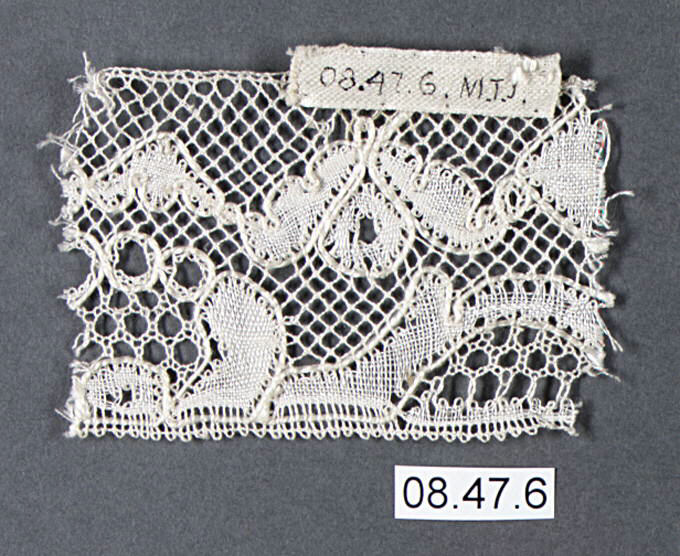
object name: fragment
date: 1801-1900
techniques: lace